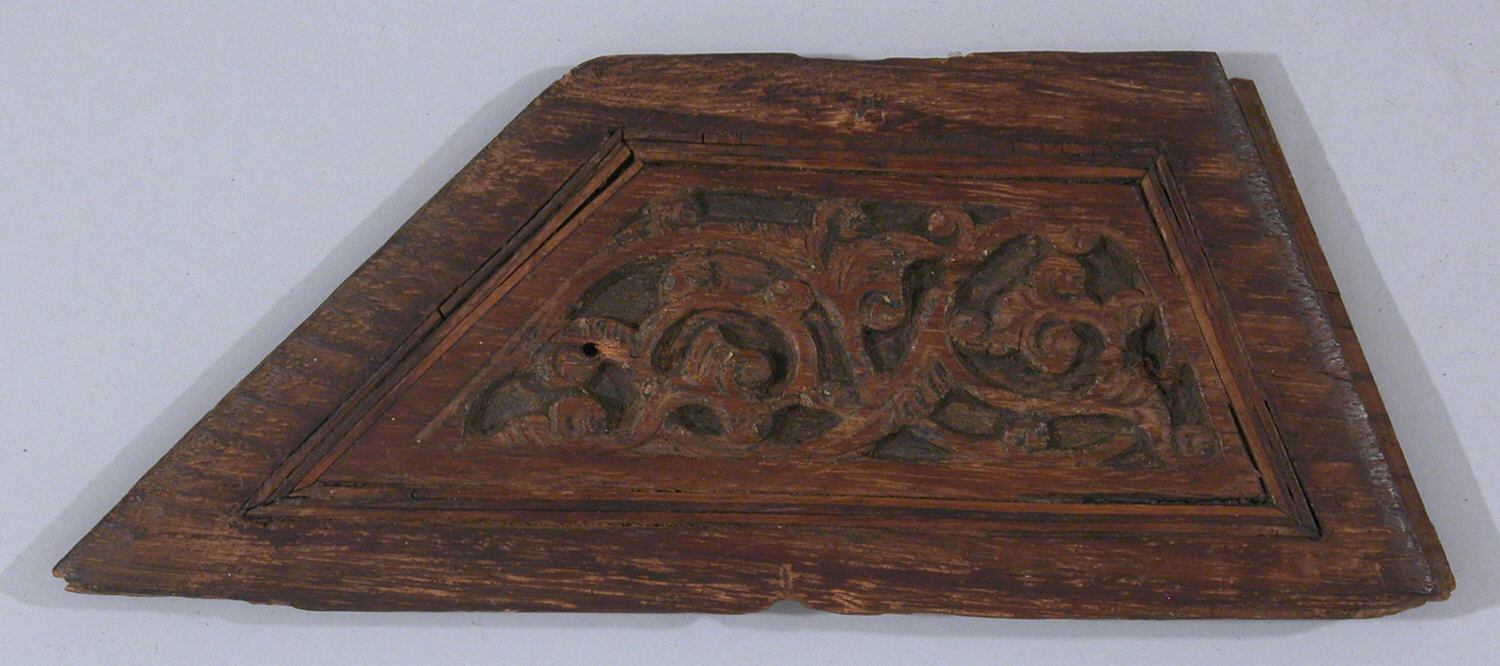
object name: panel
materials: wood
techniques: carving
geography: egypt